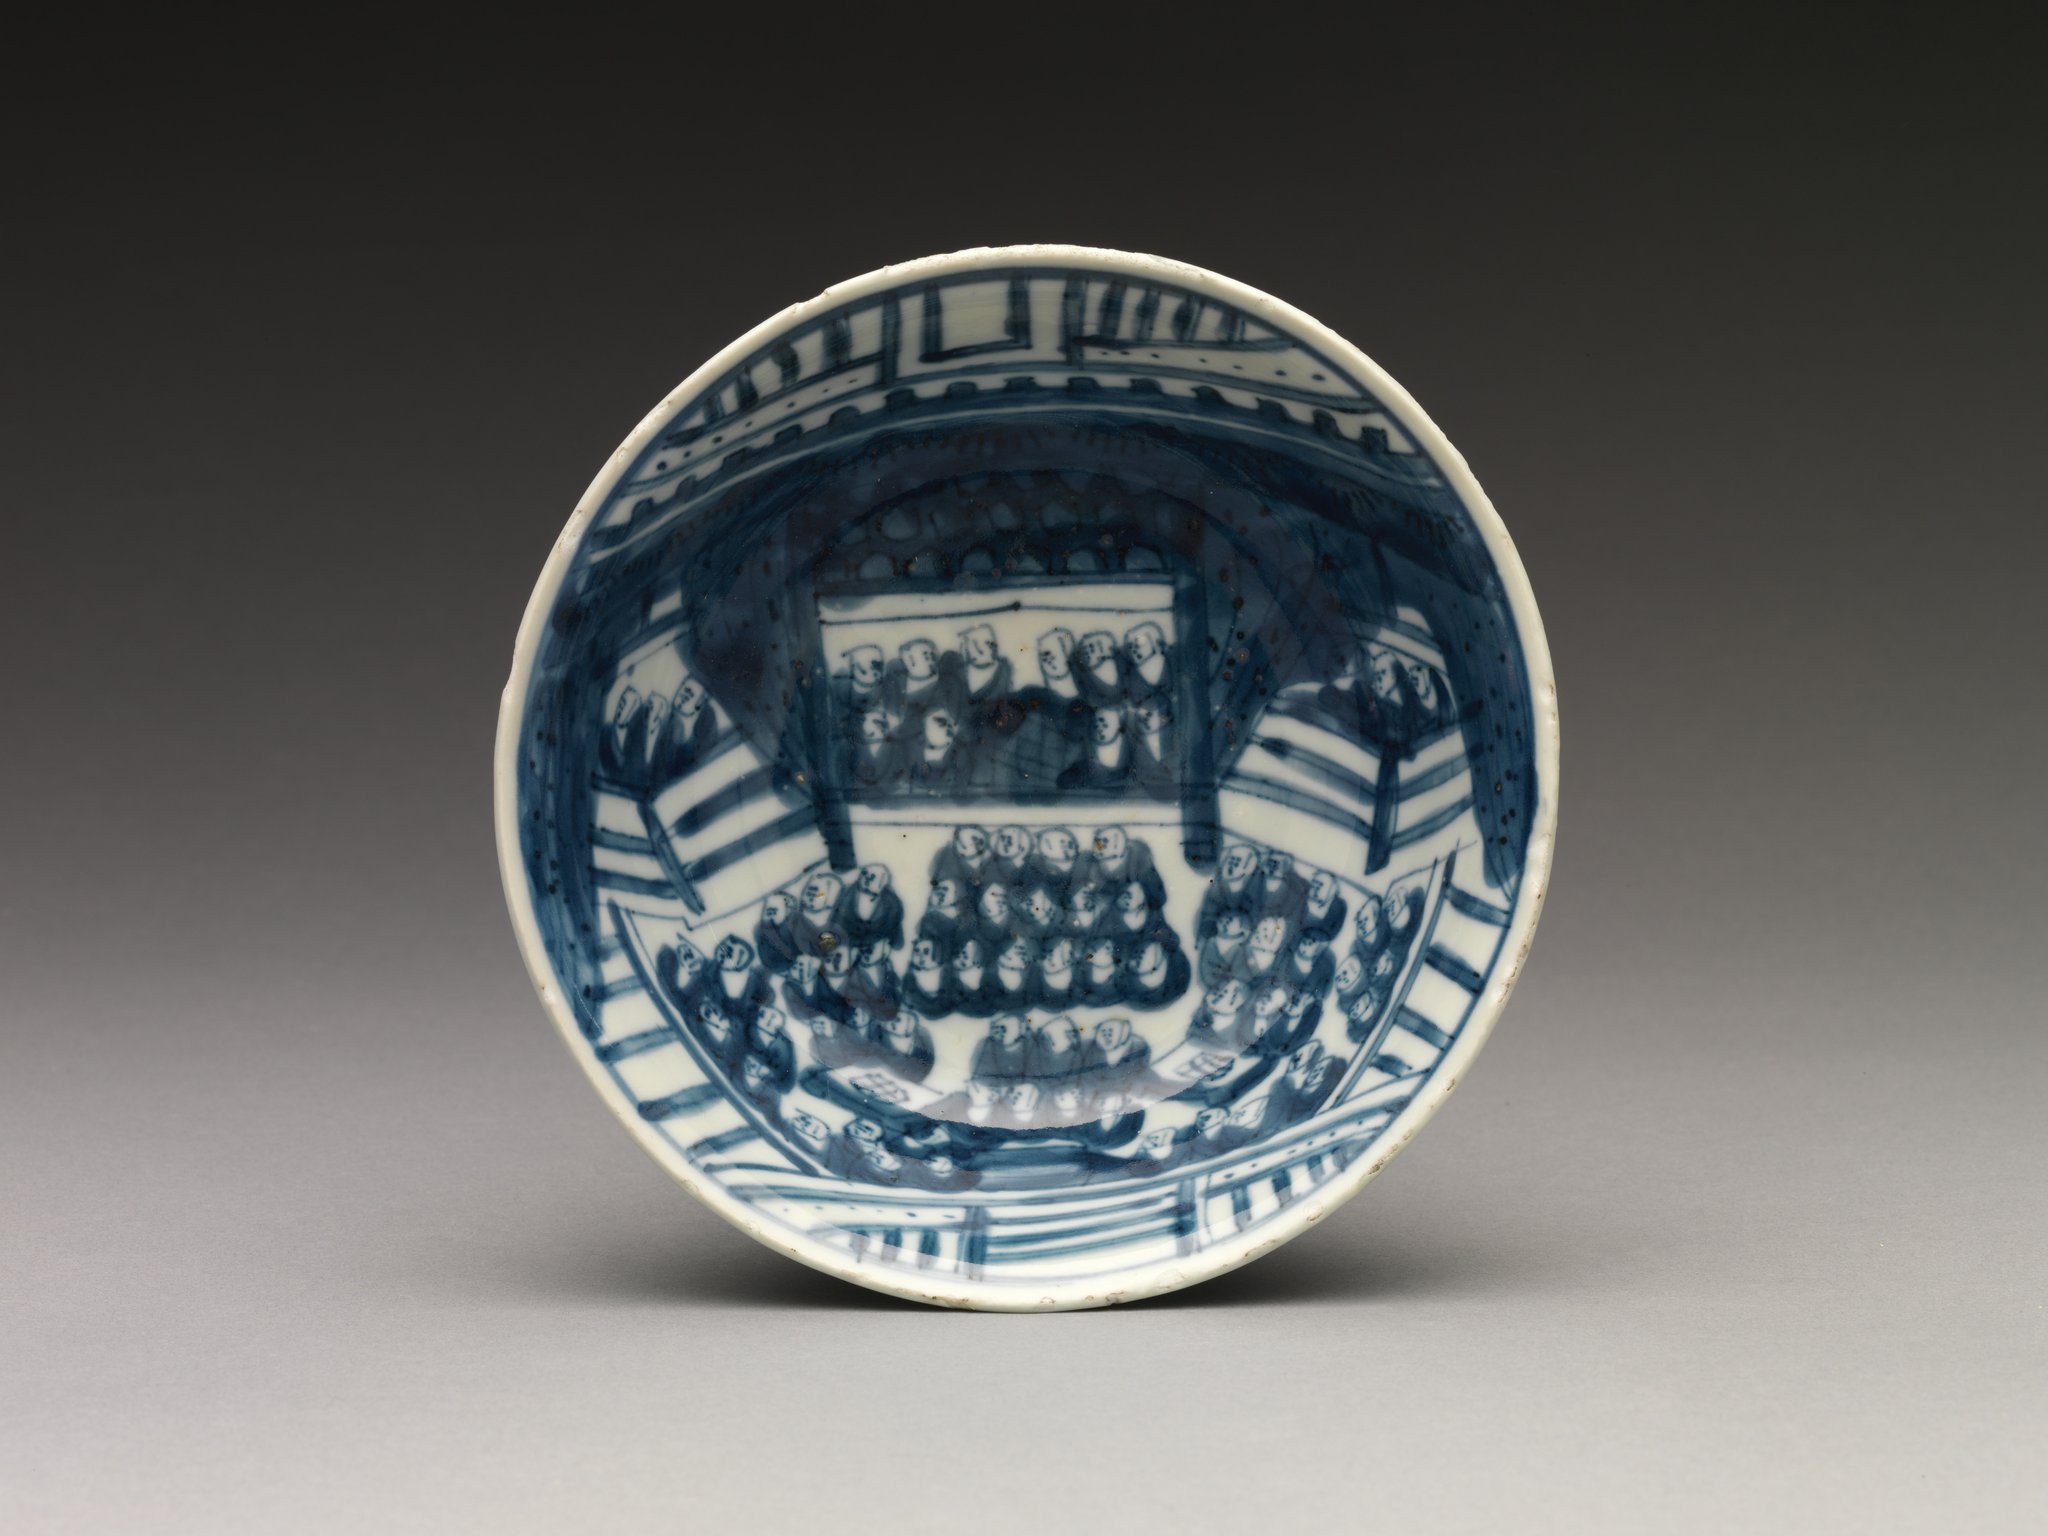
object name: bowl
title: Bowl with Buddhist Assembly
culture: chinese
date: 1620-1627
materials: cobalt, glaze, porcelain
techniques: painting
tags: human figures,buddhism